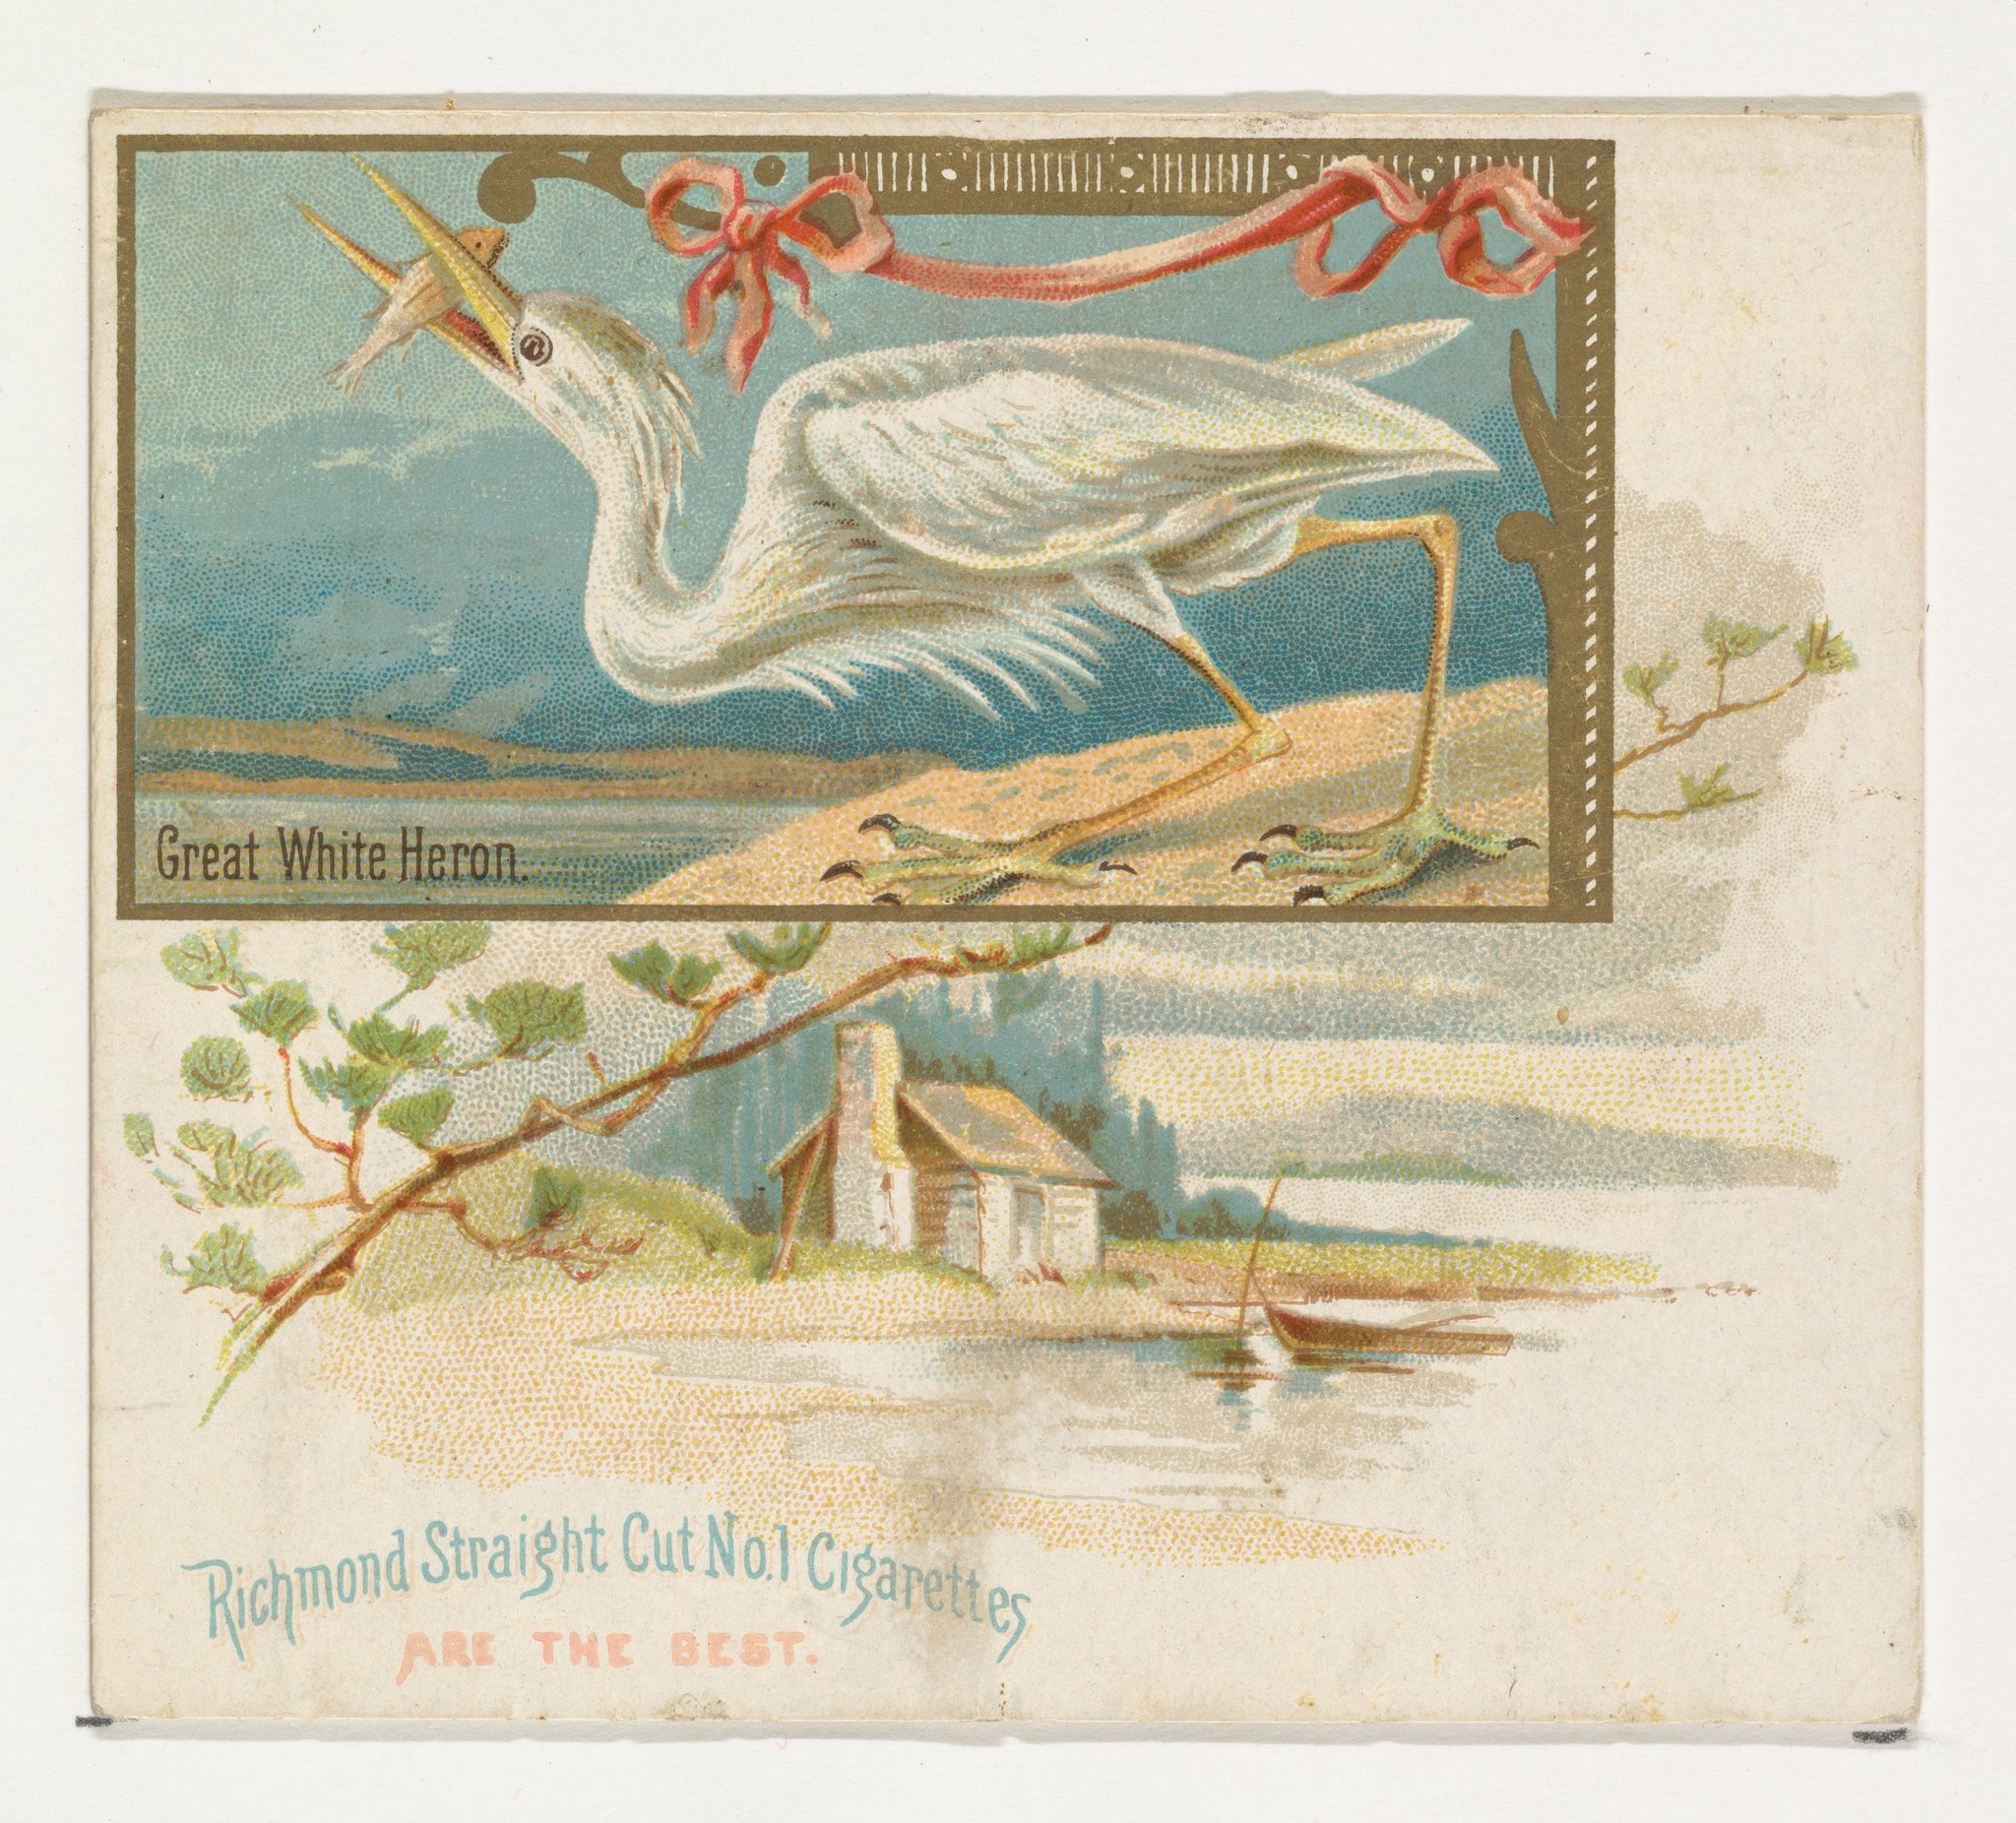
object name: print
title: Great White Heron, from the Game Birds series (N40) for Allen & Ginter Cigarettes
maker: allen & ginter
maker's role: publisher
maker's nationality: american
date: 1888-1890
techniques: color lithograph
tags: birds